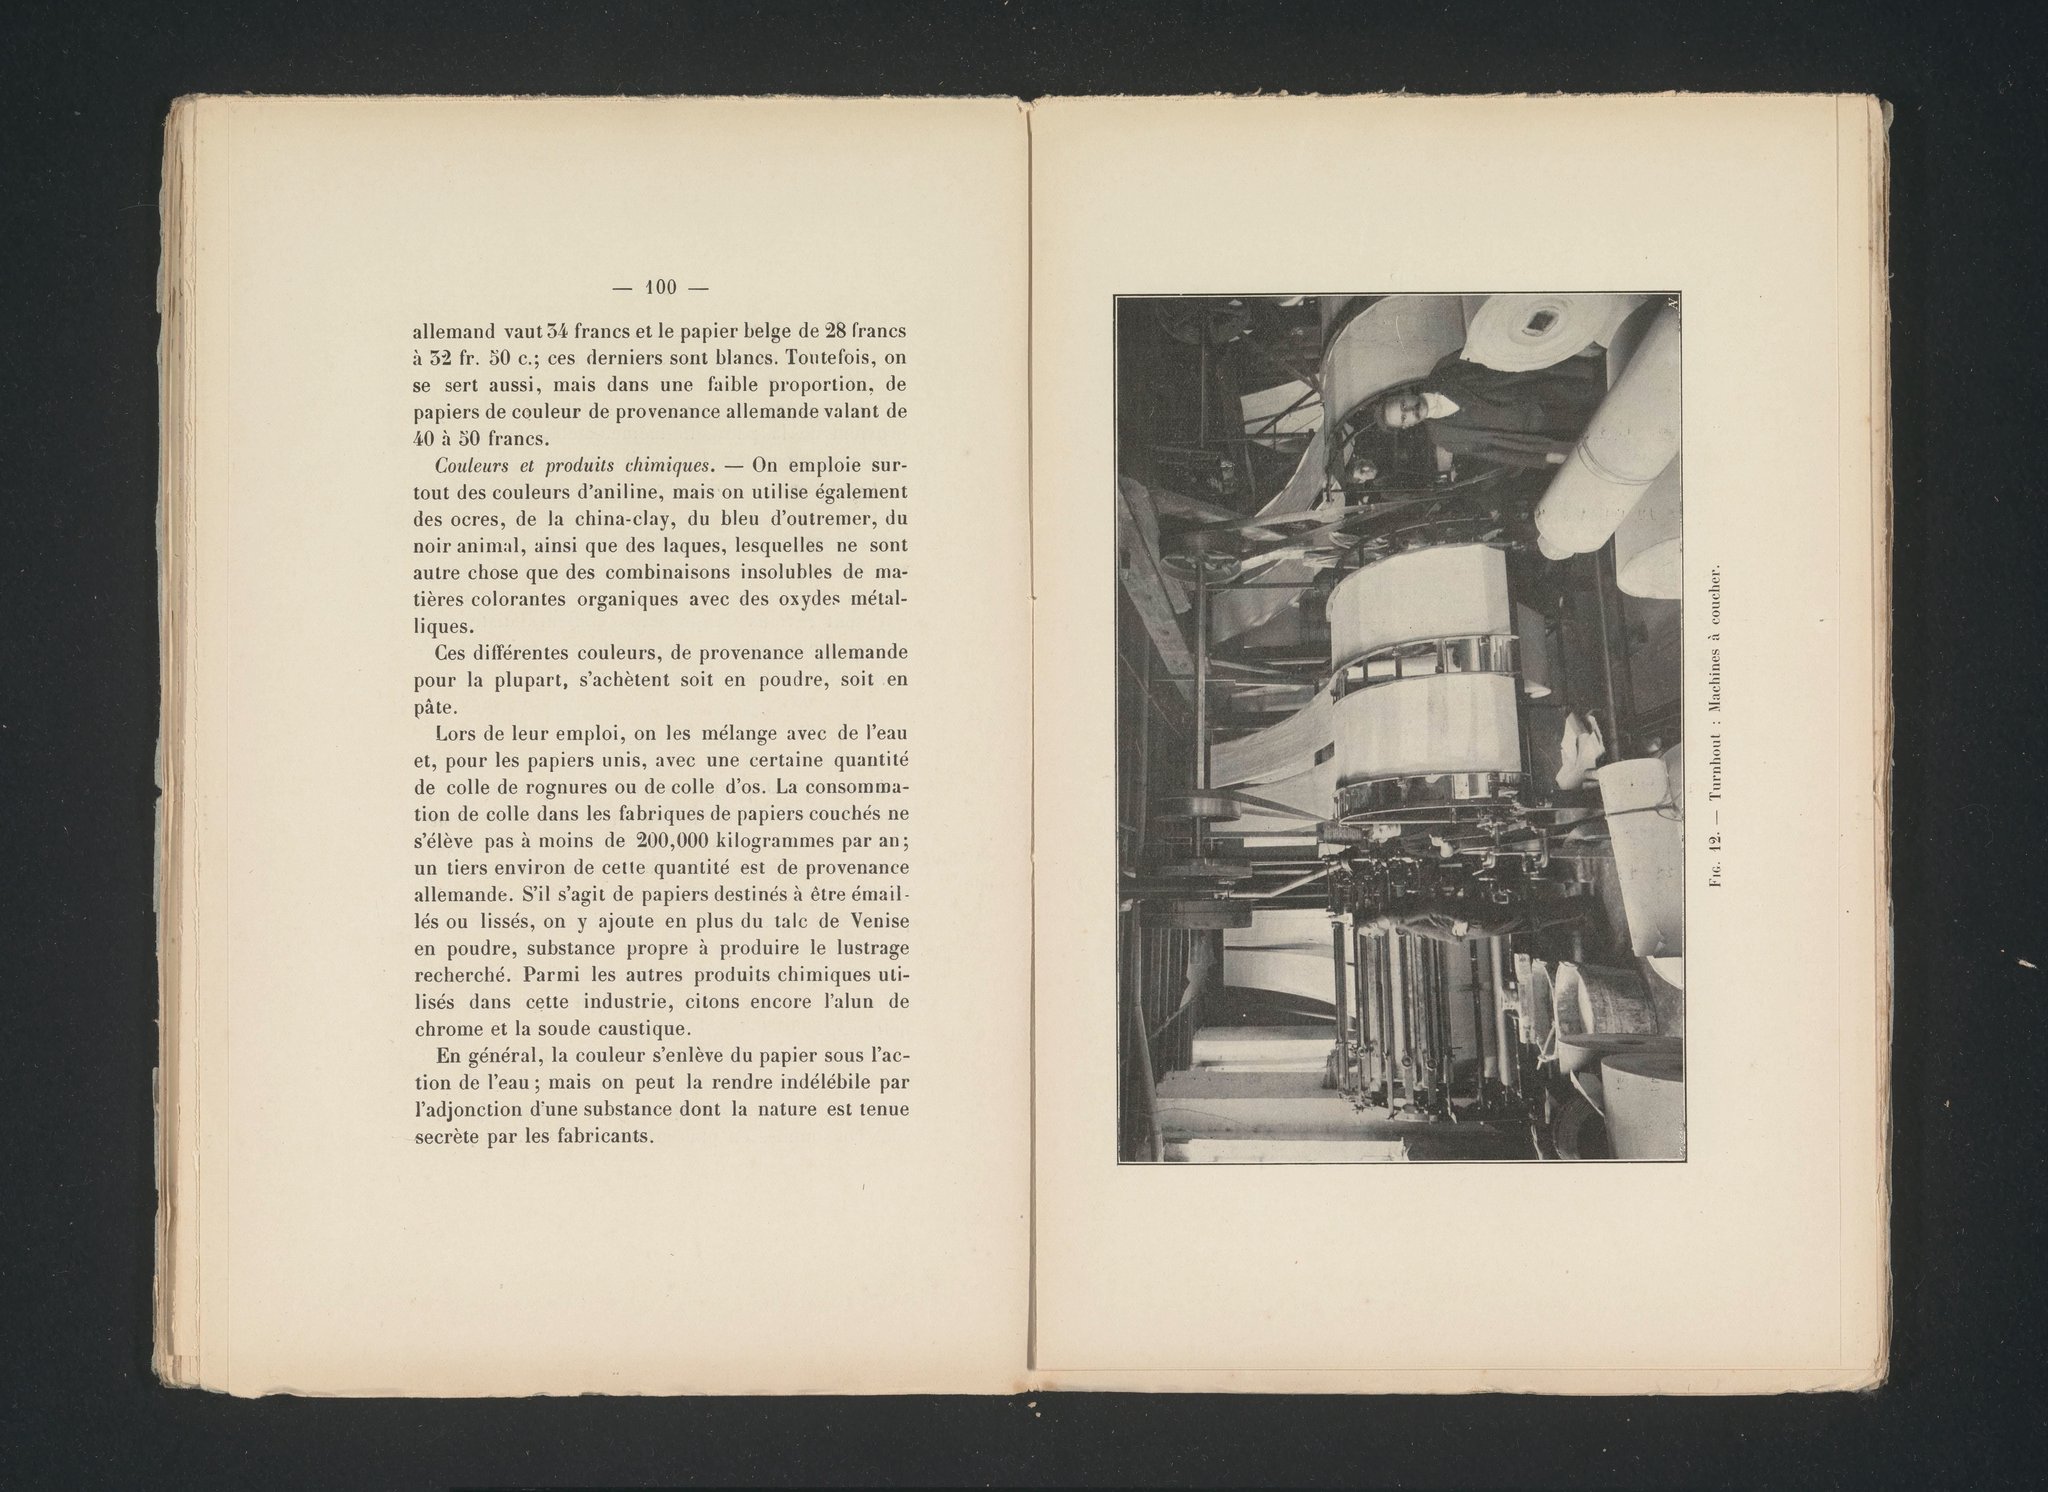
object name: page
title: Gezicht op een werkplaats in een papierfabriek in Turnhout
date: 1901-1906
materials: paper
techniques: autotype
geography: turnhout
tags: paper (writing material), workshop-interior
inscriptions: monogram: ‘AN’, inscription: ‘Fig. 12. - Turnhout: Machines à coucher.’